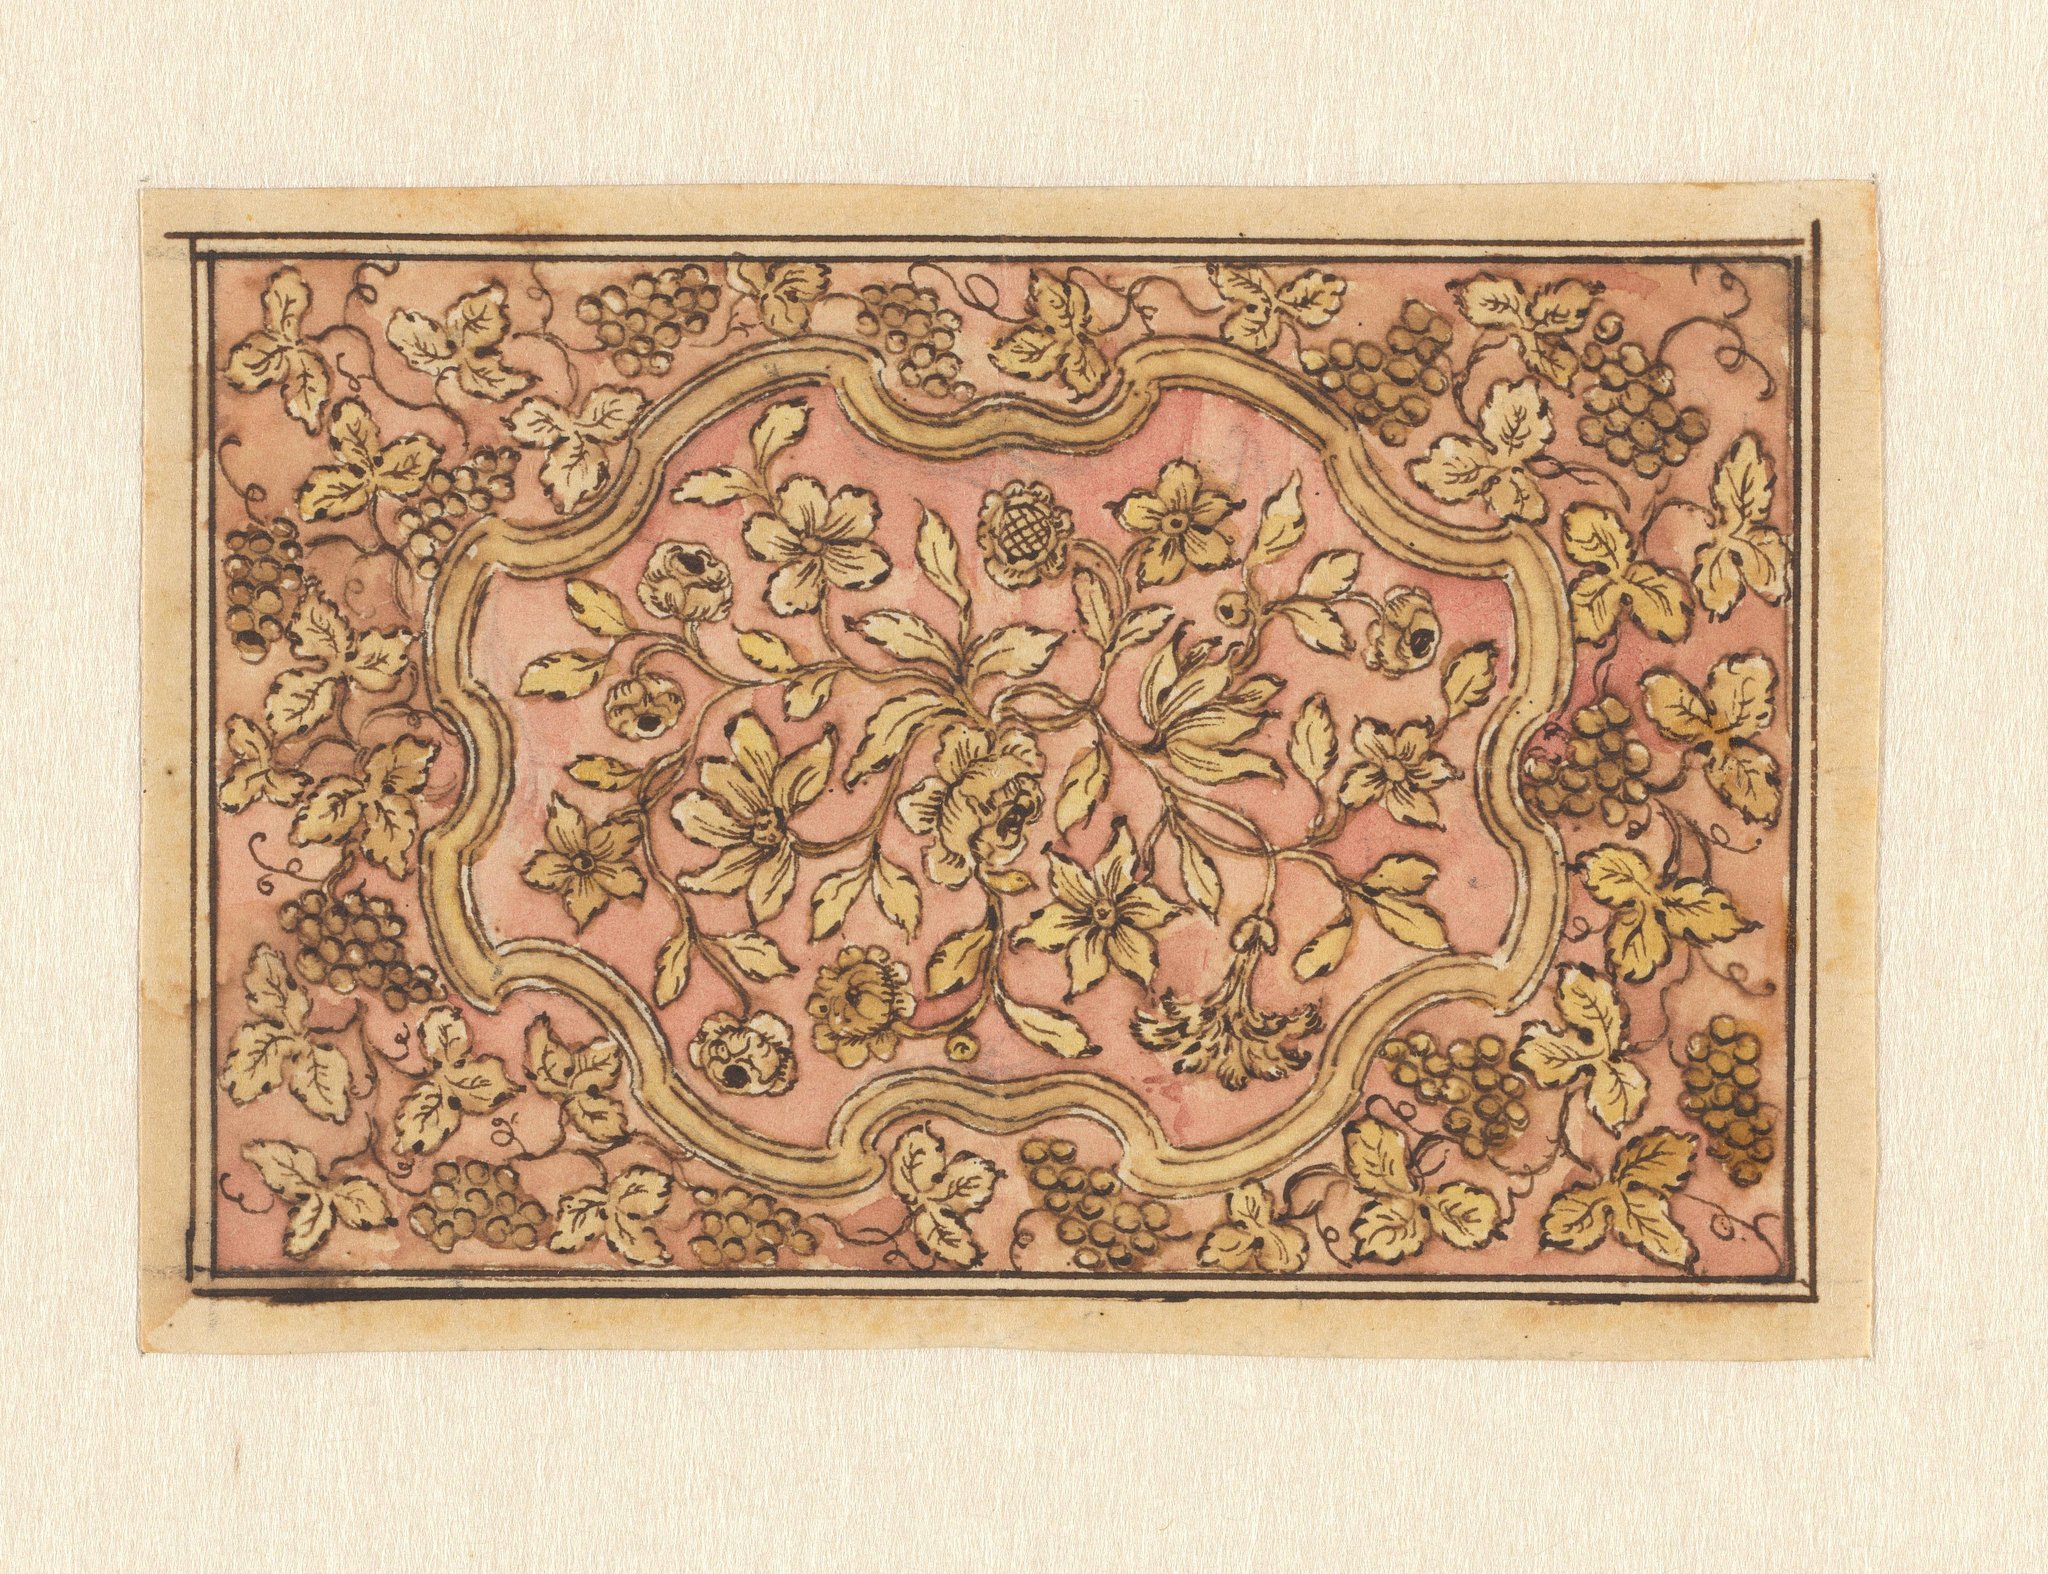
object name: design drawing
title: Snuifdoos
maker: Anonymous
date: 1740-1750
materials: graphite, ink, paper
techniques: brush, pen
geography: paris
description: Ontwerp voor het deksel van een rechthoekige snuifdoos, met bloemen binnen een cartouche, waarbuiten druivenranken.